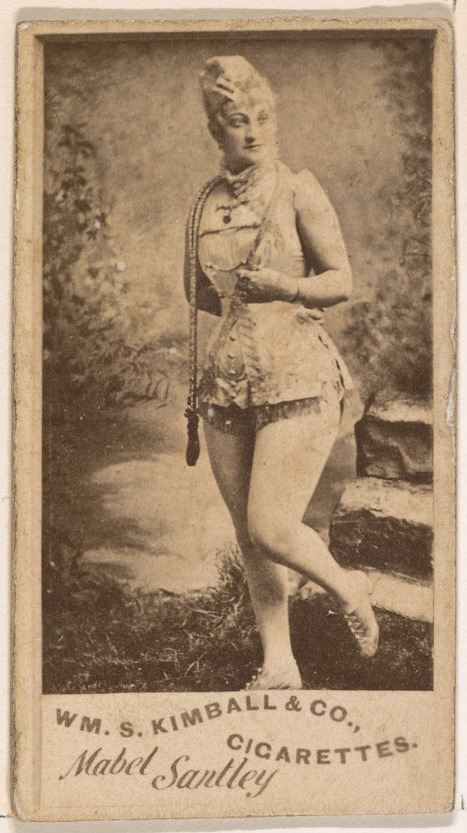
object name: photograph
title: Mabel Santley, from the Actresses series (N203) issued by Wm. S. Kimball & Co.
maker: william s. kimball & company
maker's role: publisher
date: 1889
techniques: color lithograph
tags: portraits,women,actresses